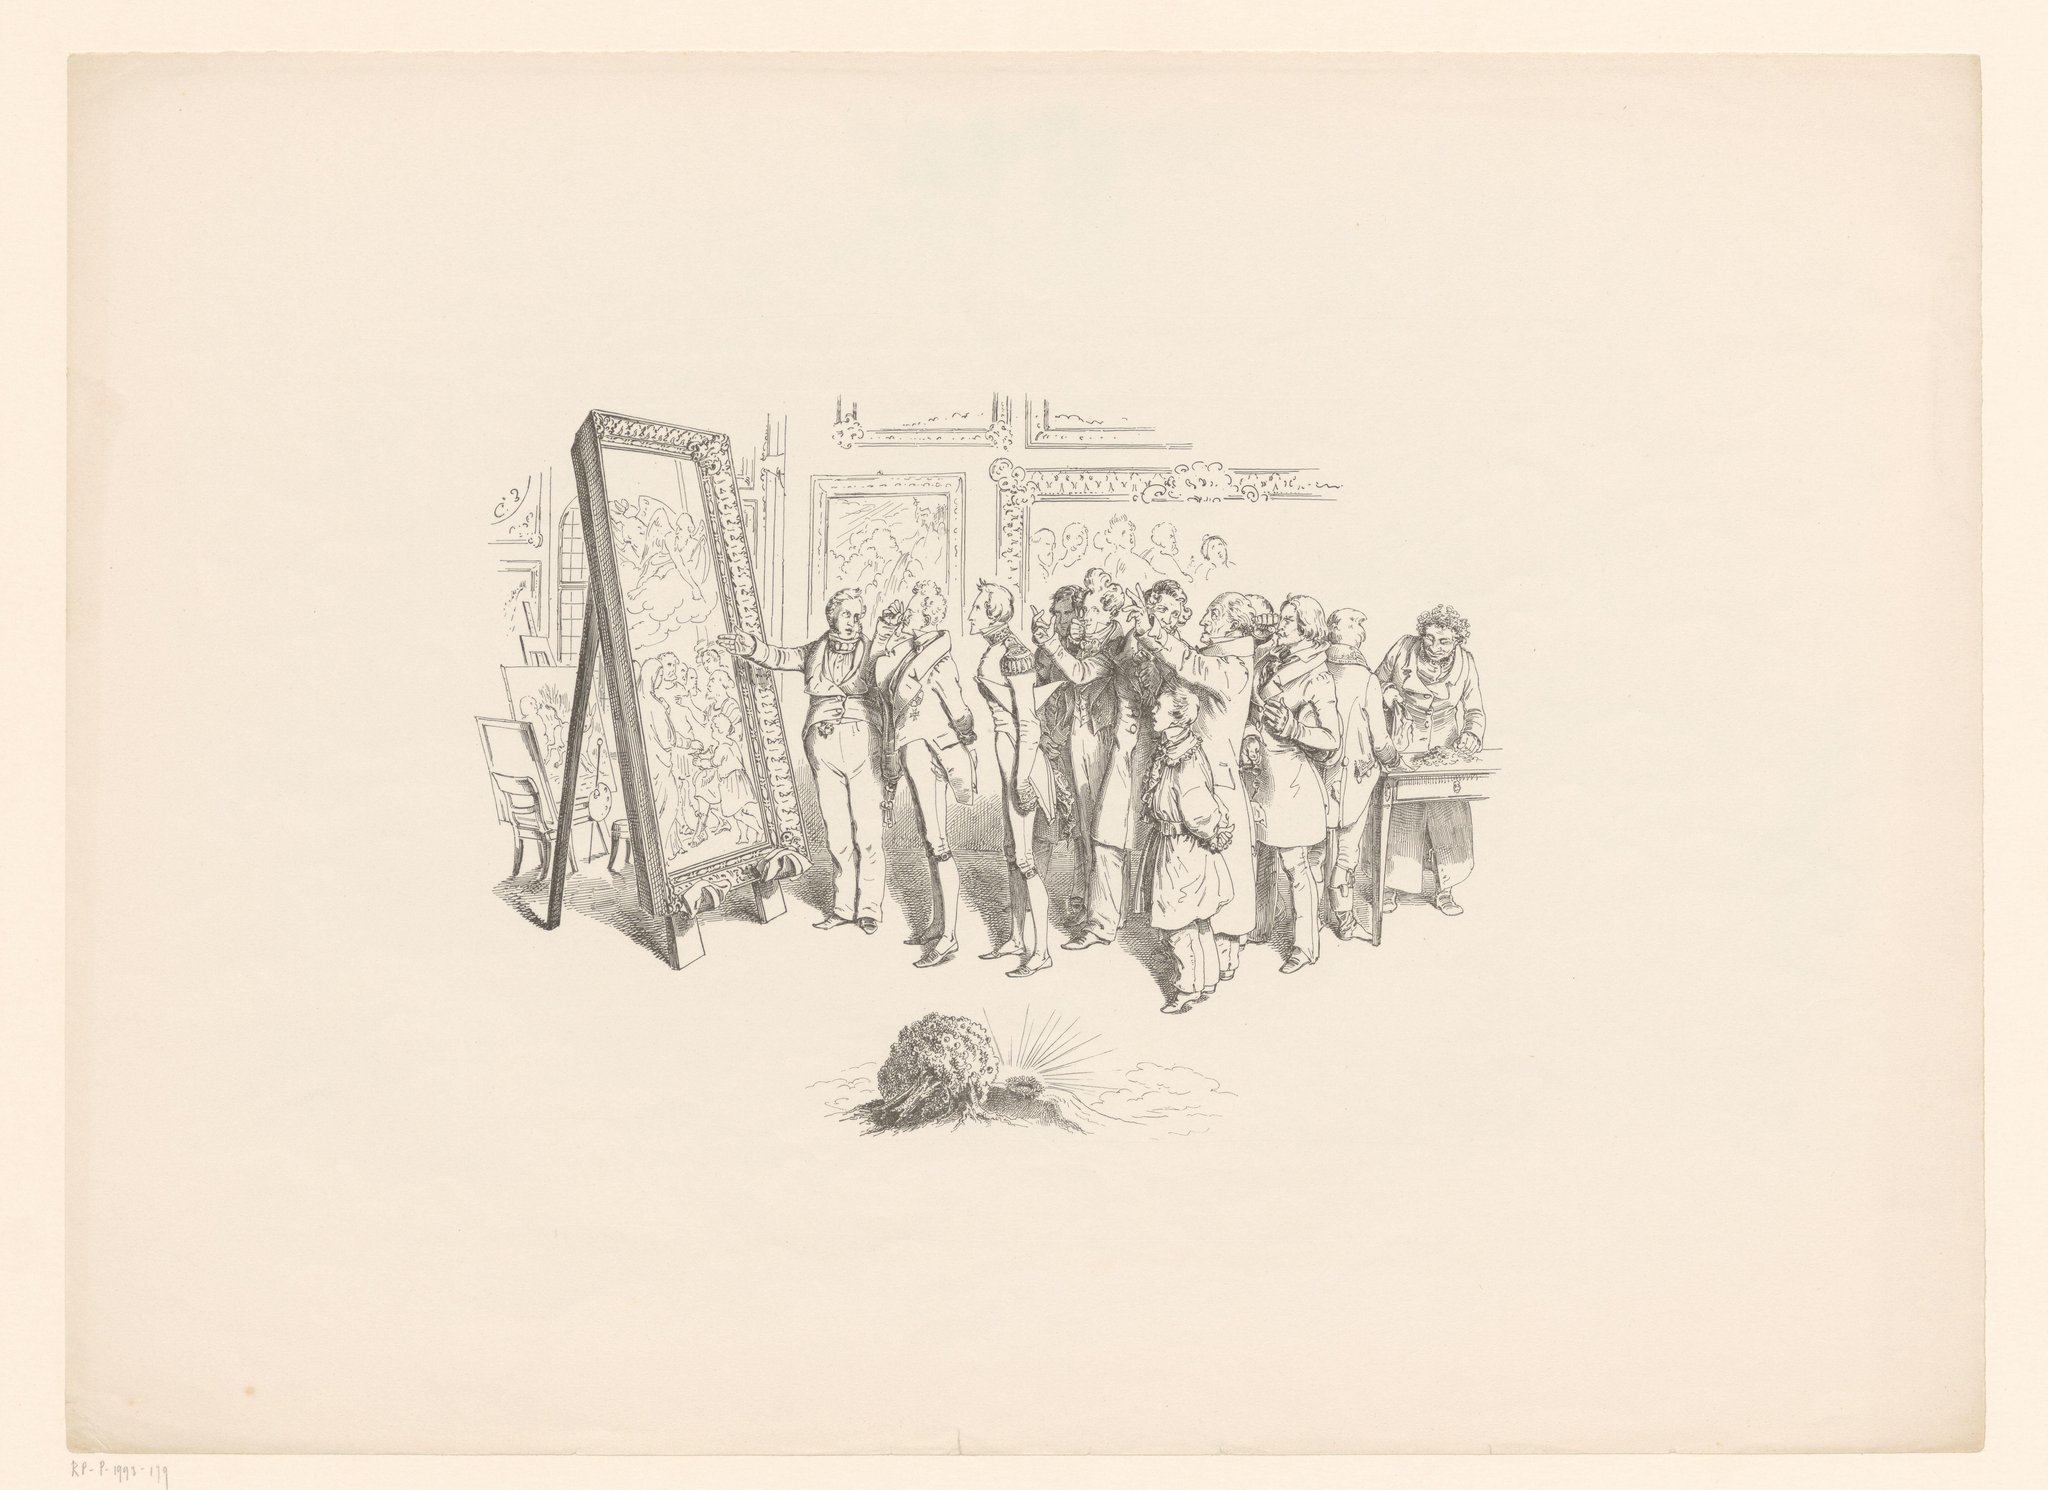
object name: print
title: Publiek bewondert een schilderij op een tentoonstelling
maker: adolph menzel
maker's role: draughtsman, painter, print maker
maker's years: 1815-1905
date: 1834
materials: paper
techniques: pen lithography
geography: berlin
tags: criticizing and discussing art, art criticism, exhibition ~ art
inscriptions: collector's mark: Lugt 2760, collector's mark: Lugt 2228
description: Publiek bewondert het werk van de kunstenaar op een tentoonstelling en discussieert er over. Zo krijgt de kunstenaar (waarschijnlijk na zijn dood) toch nog waardering voor zijn werk.